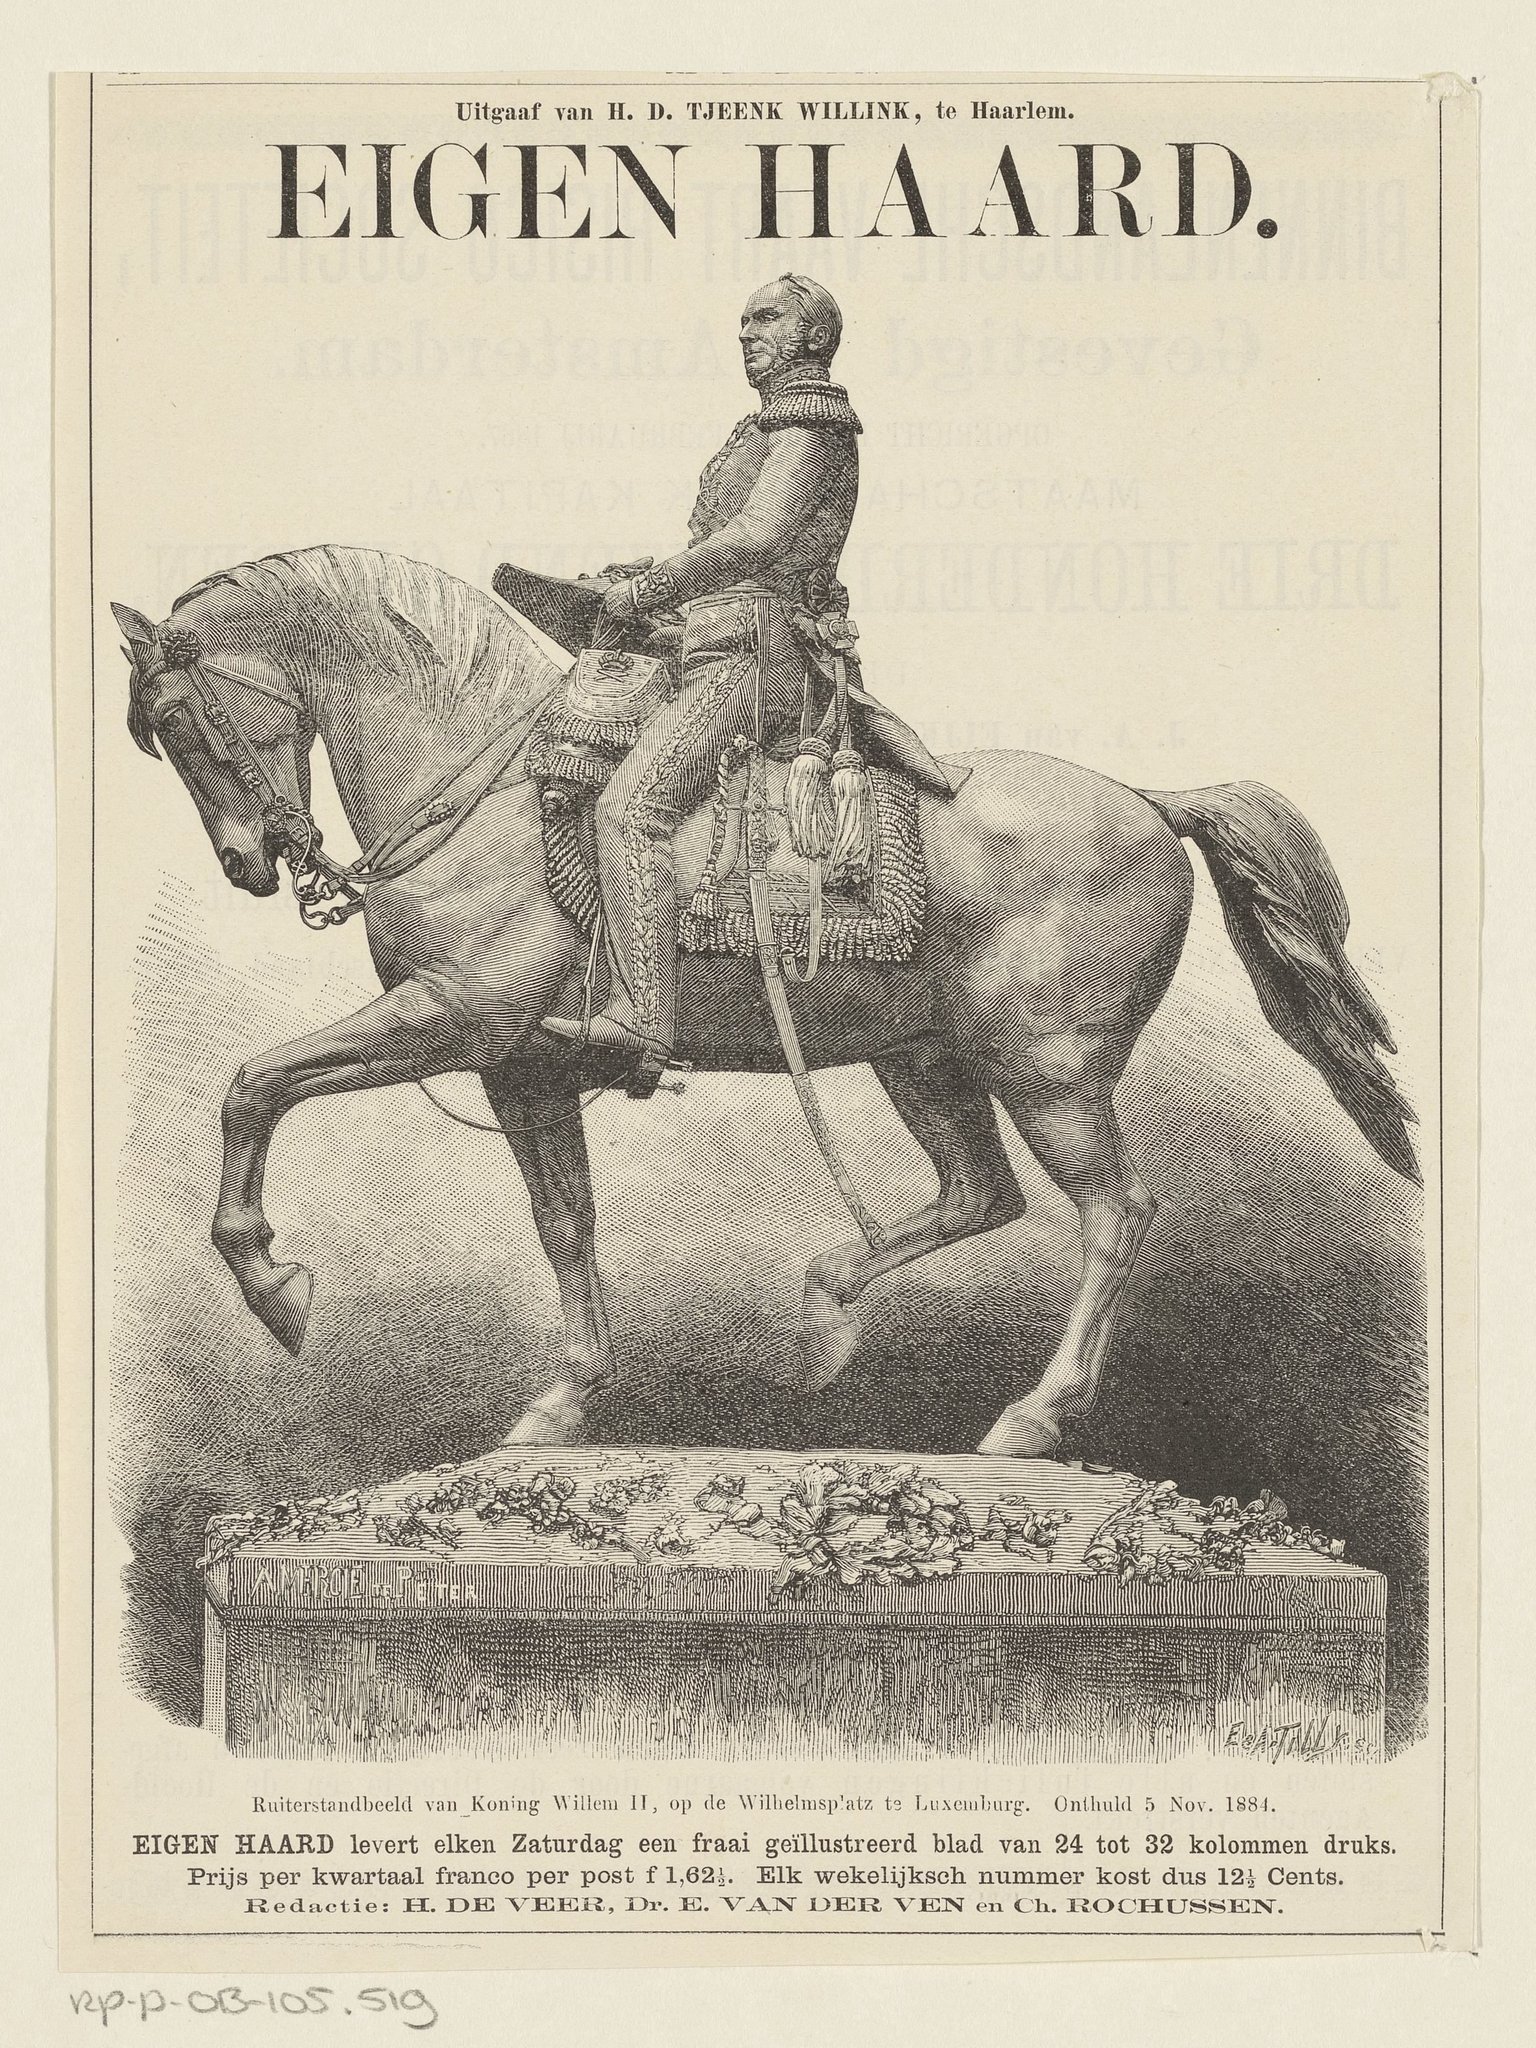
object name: print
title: Ruiterstandbeeld van Willem II, koning der Nederlanden, op het Place Guillaume II te Luxemburg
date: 1884-1890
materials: paper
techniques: letterpress printing, engraving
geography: haarlem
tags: william ii of the netherlands, equestrian statue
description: De hier vermelde titel verwijst naar de hoogst verkregen titel van de geportretteerde, niet per se naar de titel die de geportretteerde op deze voorstelling draagt.